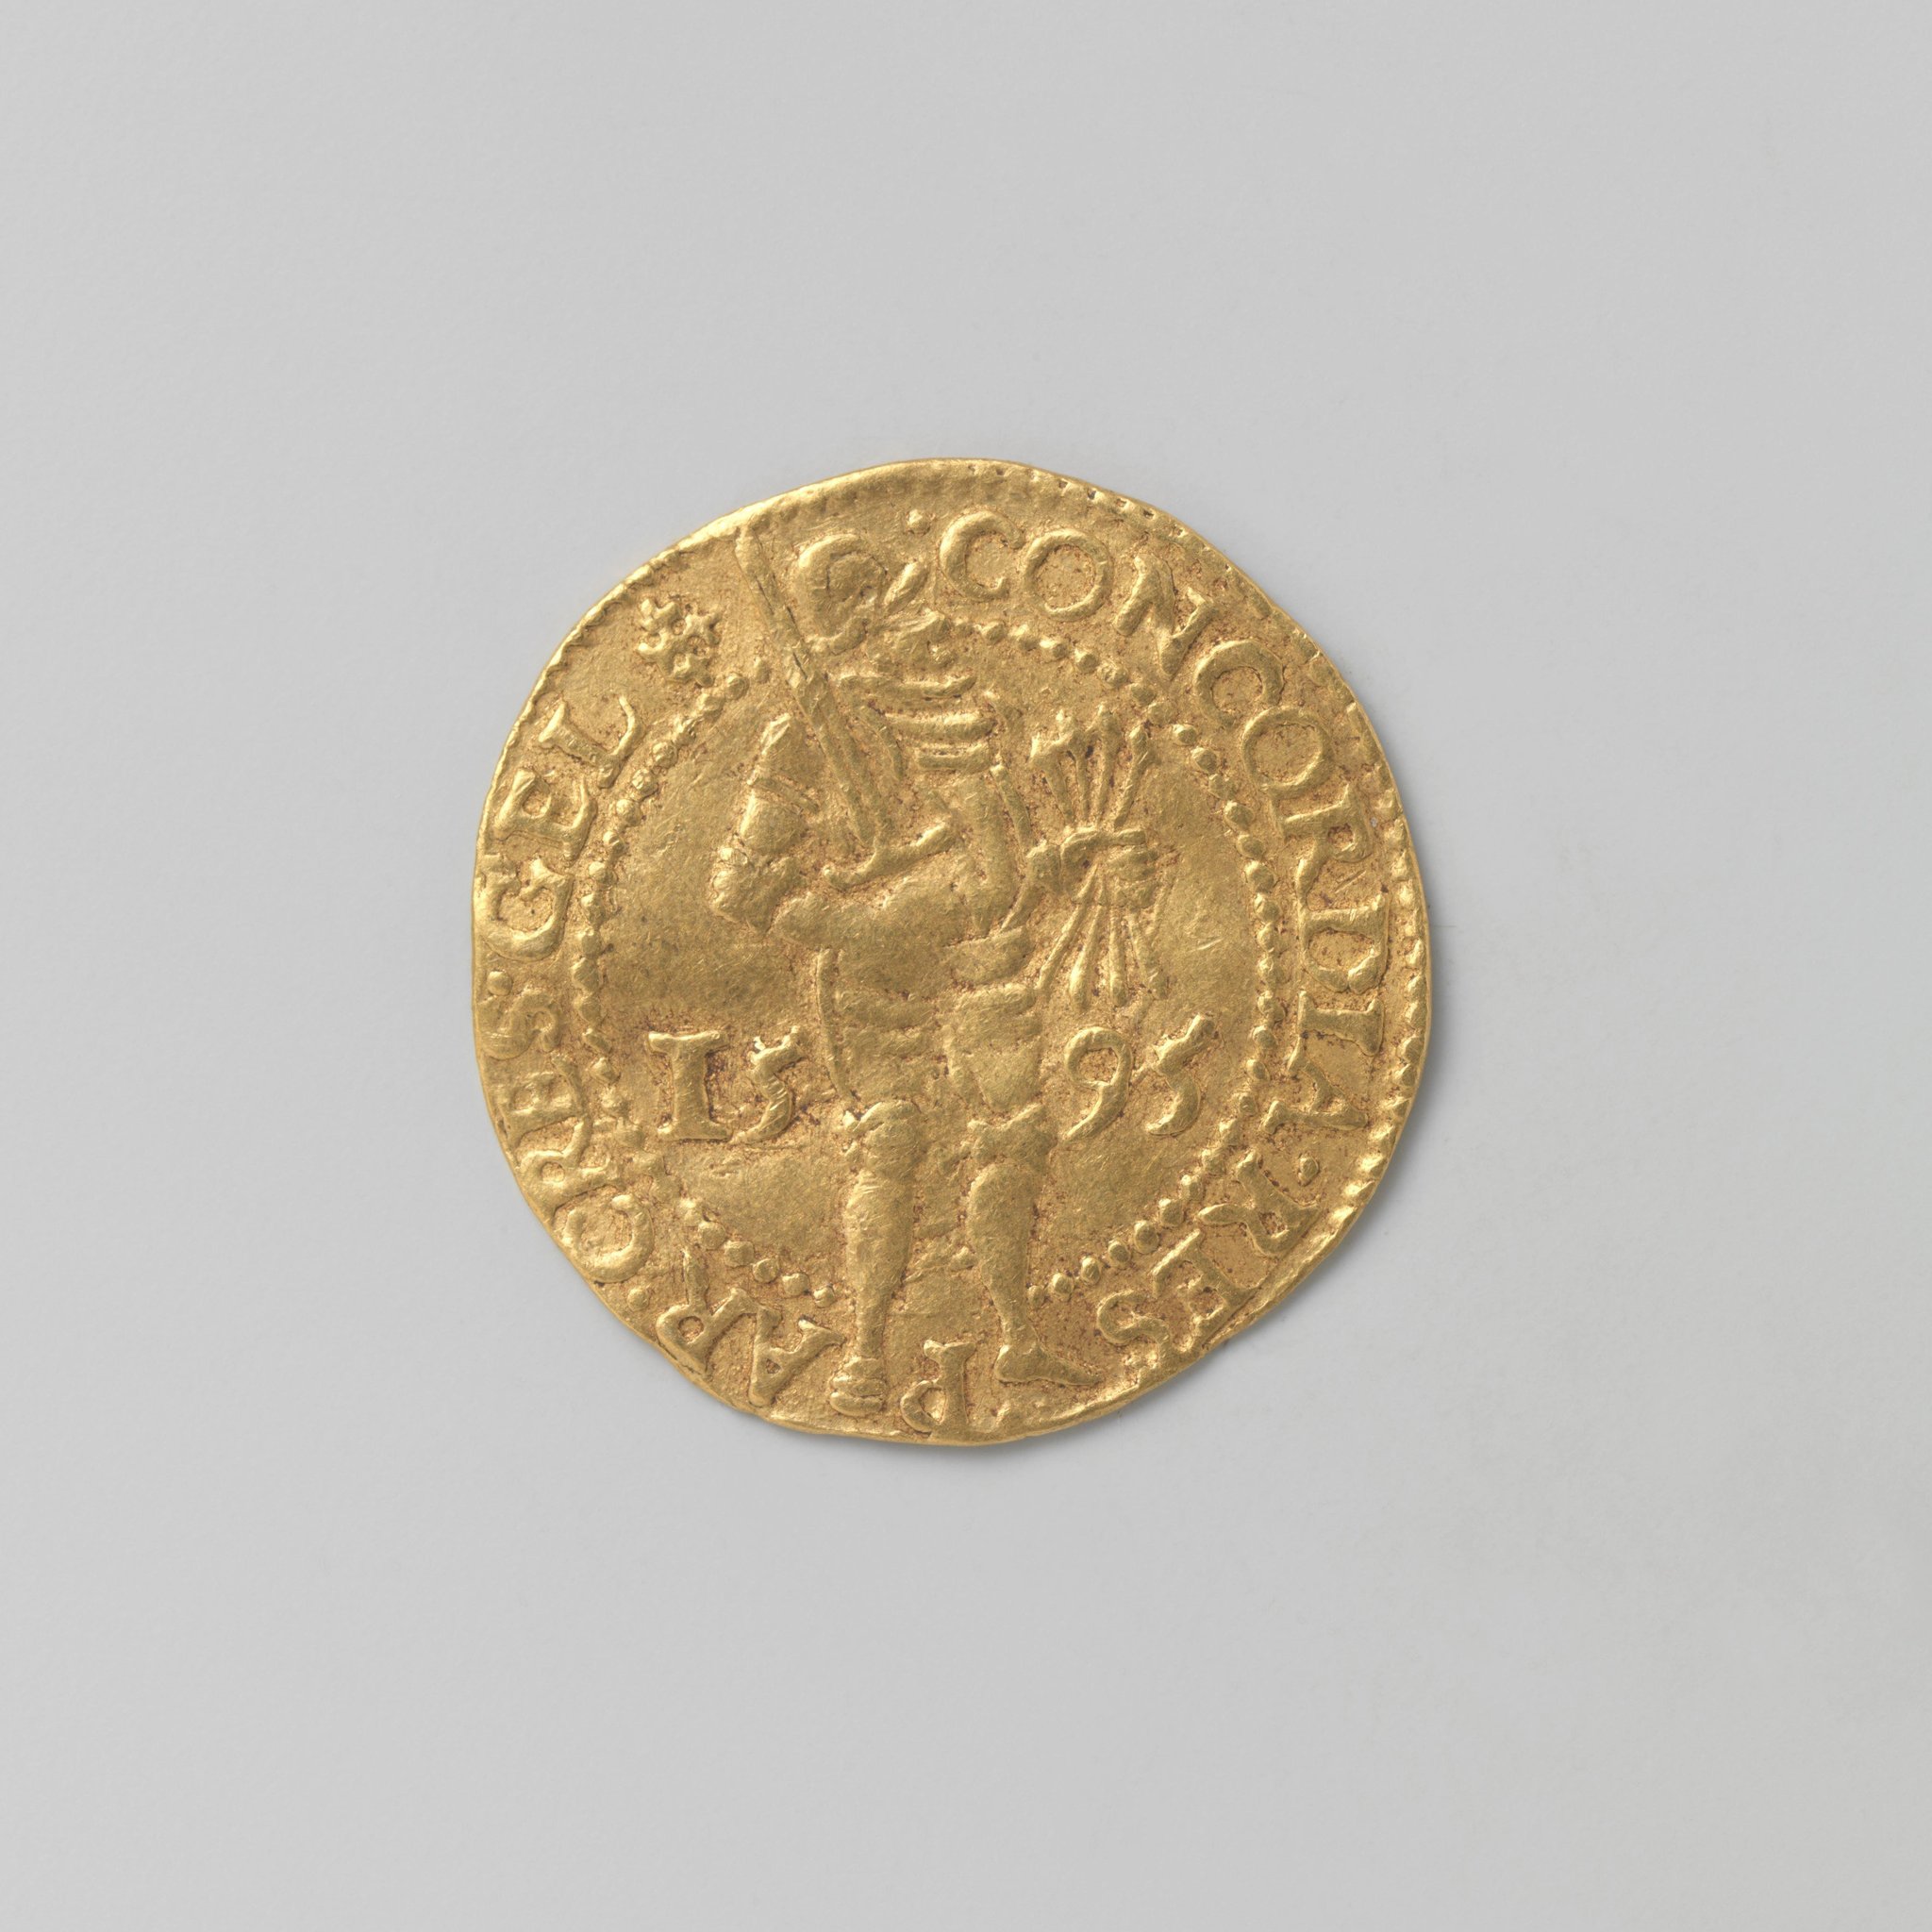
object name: coin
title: Gelderse dukaat, 1595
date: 1595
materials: gold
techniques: striking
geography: harderwijk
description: Gouden munt. Voorzijde: staande ridder naar rechts met in rechterhand zwaard en in linkerhand pijlenbundel. Keerzijde: in versierd vierkant tekst.